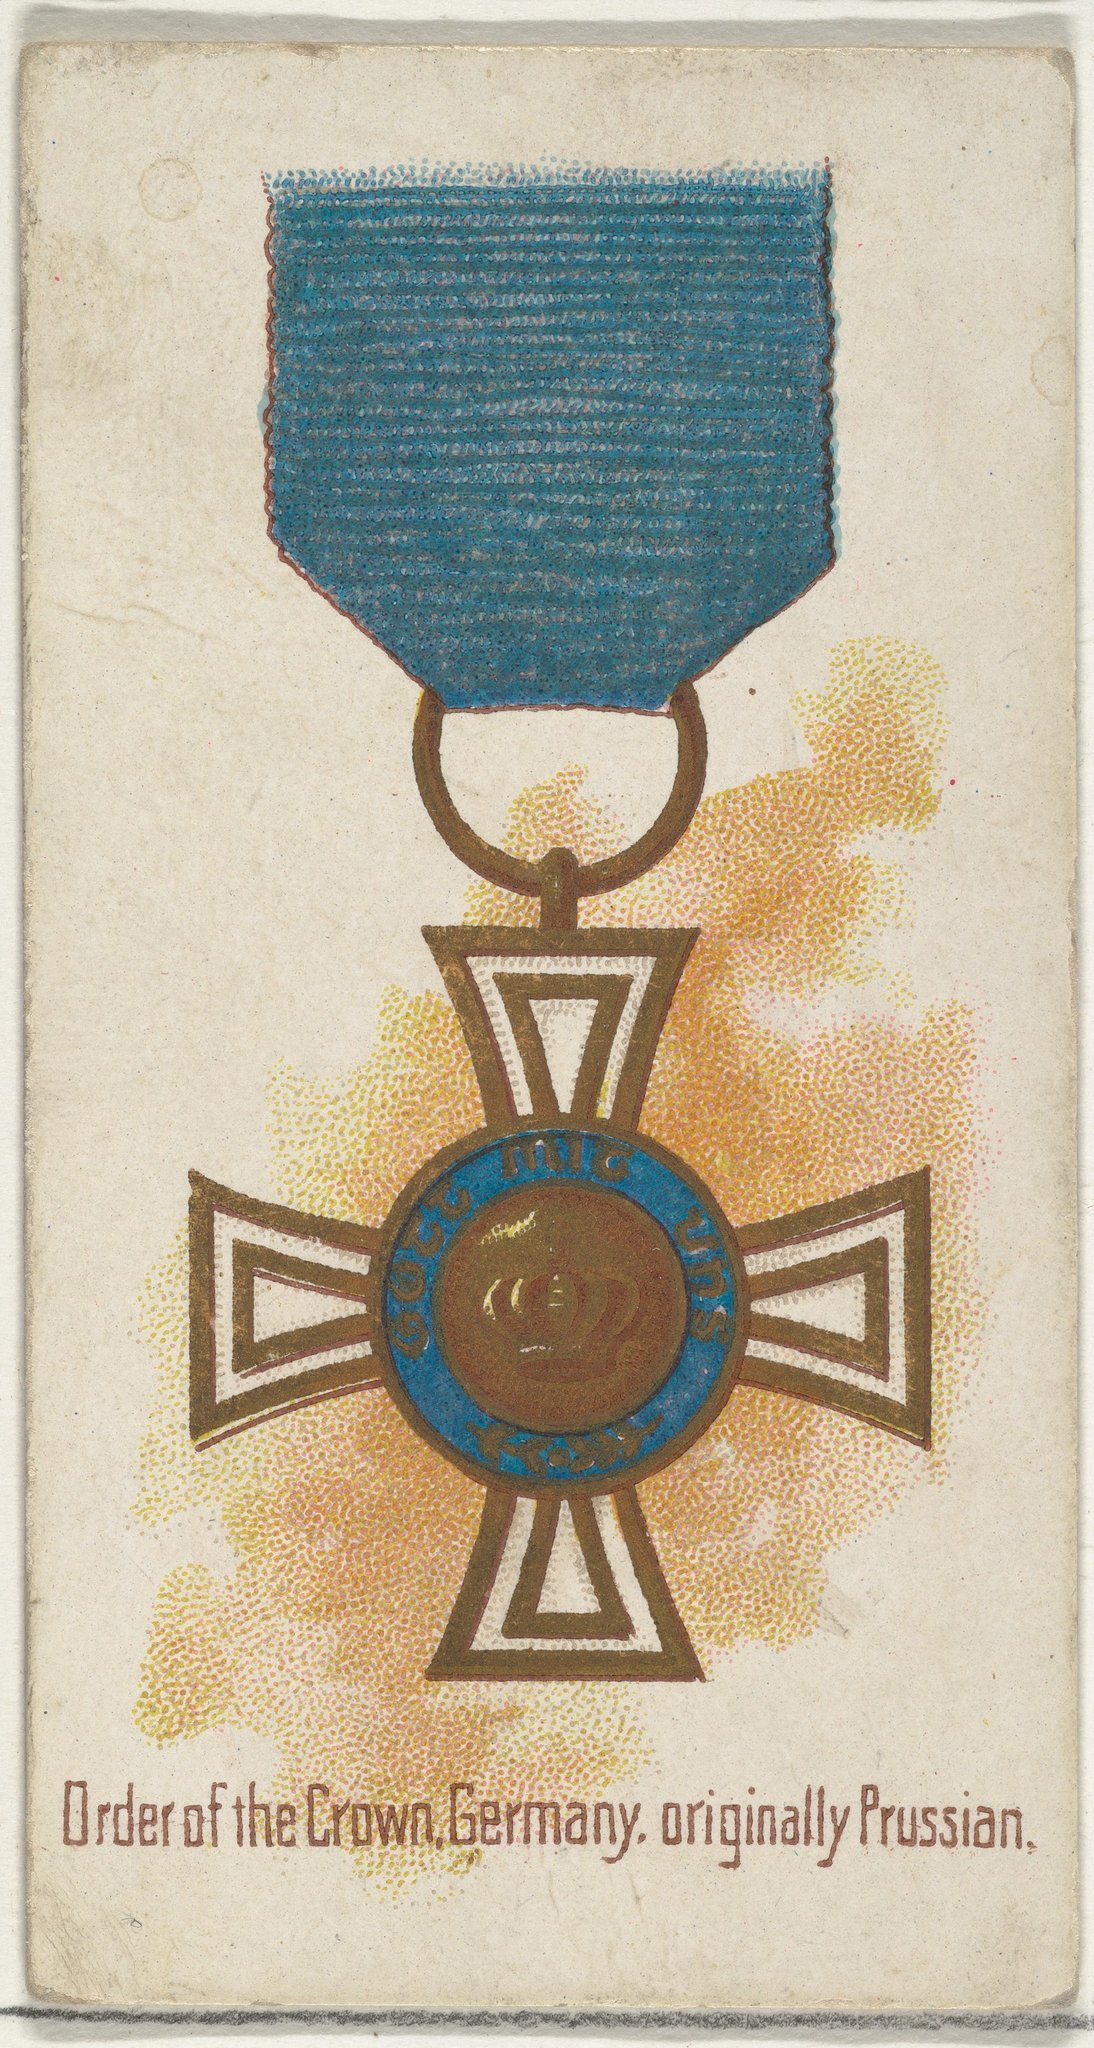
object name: print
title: Order of the Crown, Germany, originally Prussian, from the World's Decorations series (N30) for Allen & Ginter Cigarettes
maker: allen & ginter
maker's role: publisher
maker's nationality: american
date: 1890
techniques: color lithograph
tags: medals